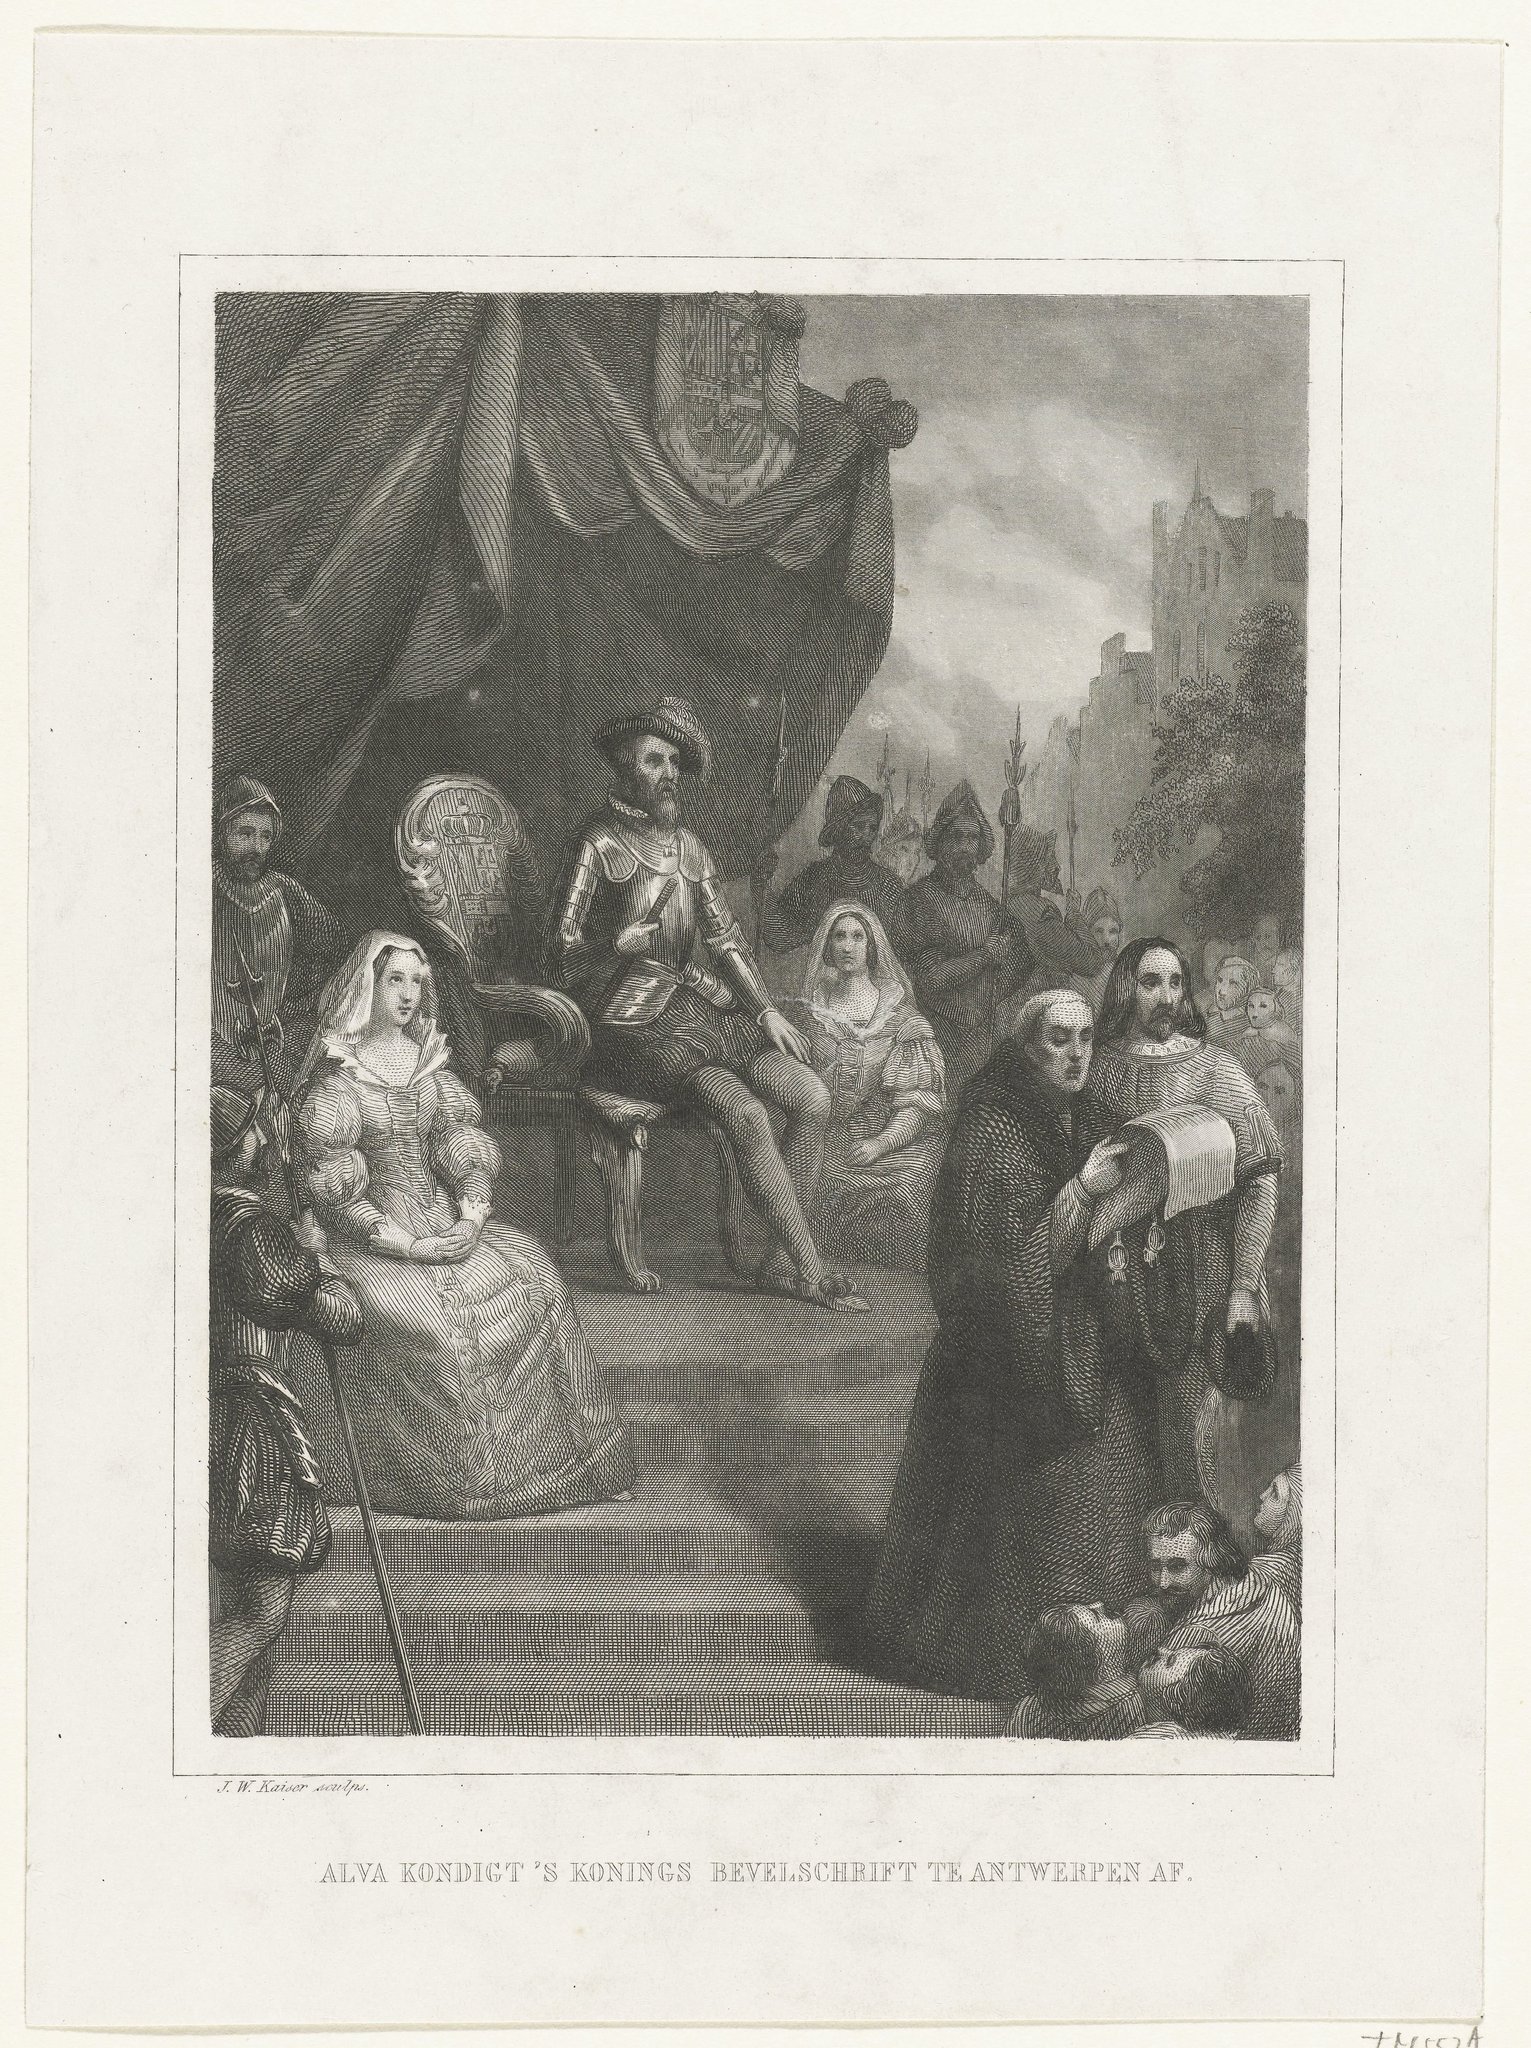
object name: print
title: Alva kondigt 's konings bevelschrift te Antwerpen af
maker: johann wilhelm kaiser (i)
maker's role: draughtsman, print maker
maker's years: 1813-1900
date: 1849-1851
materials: paper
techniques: engraving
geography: netherlands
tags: fernando álvarez de toledo (3rd duke of alba), granting mercy; free pardon, antwerp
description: Als illustratie gebruikt in: J.P. Arend, Algemeene geschiedenis des vaderlands, Amsterdam, 5 delen, 1840-1882, dl. 2.5 (1851), p. 148-149.